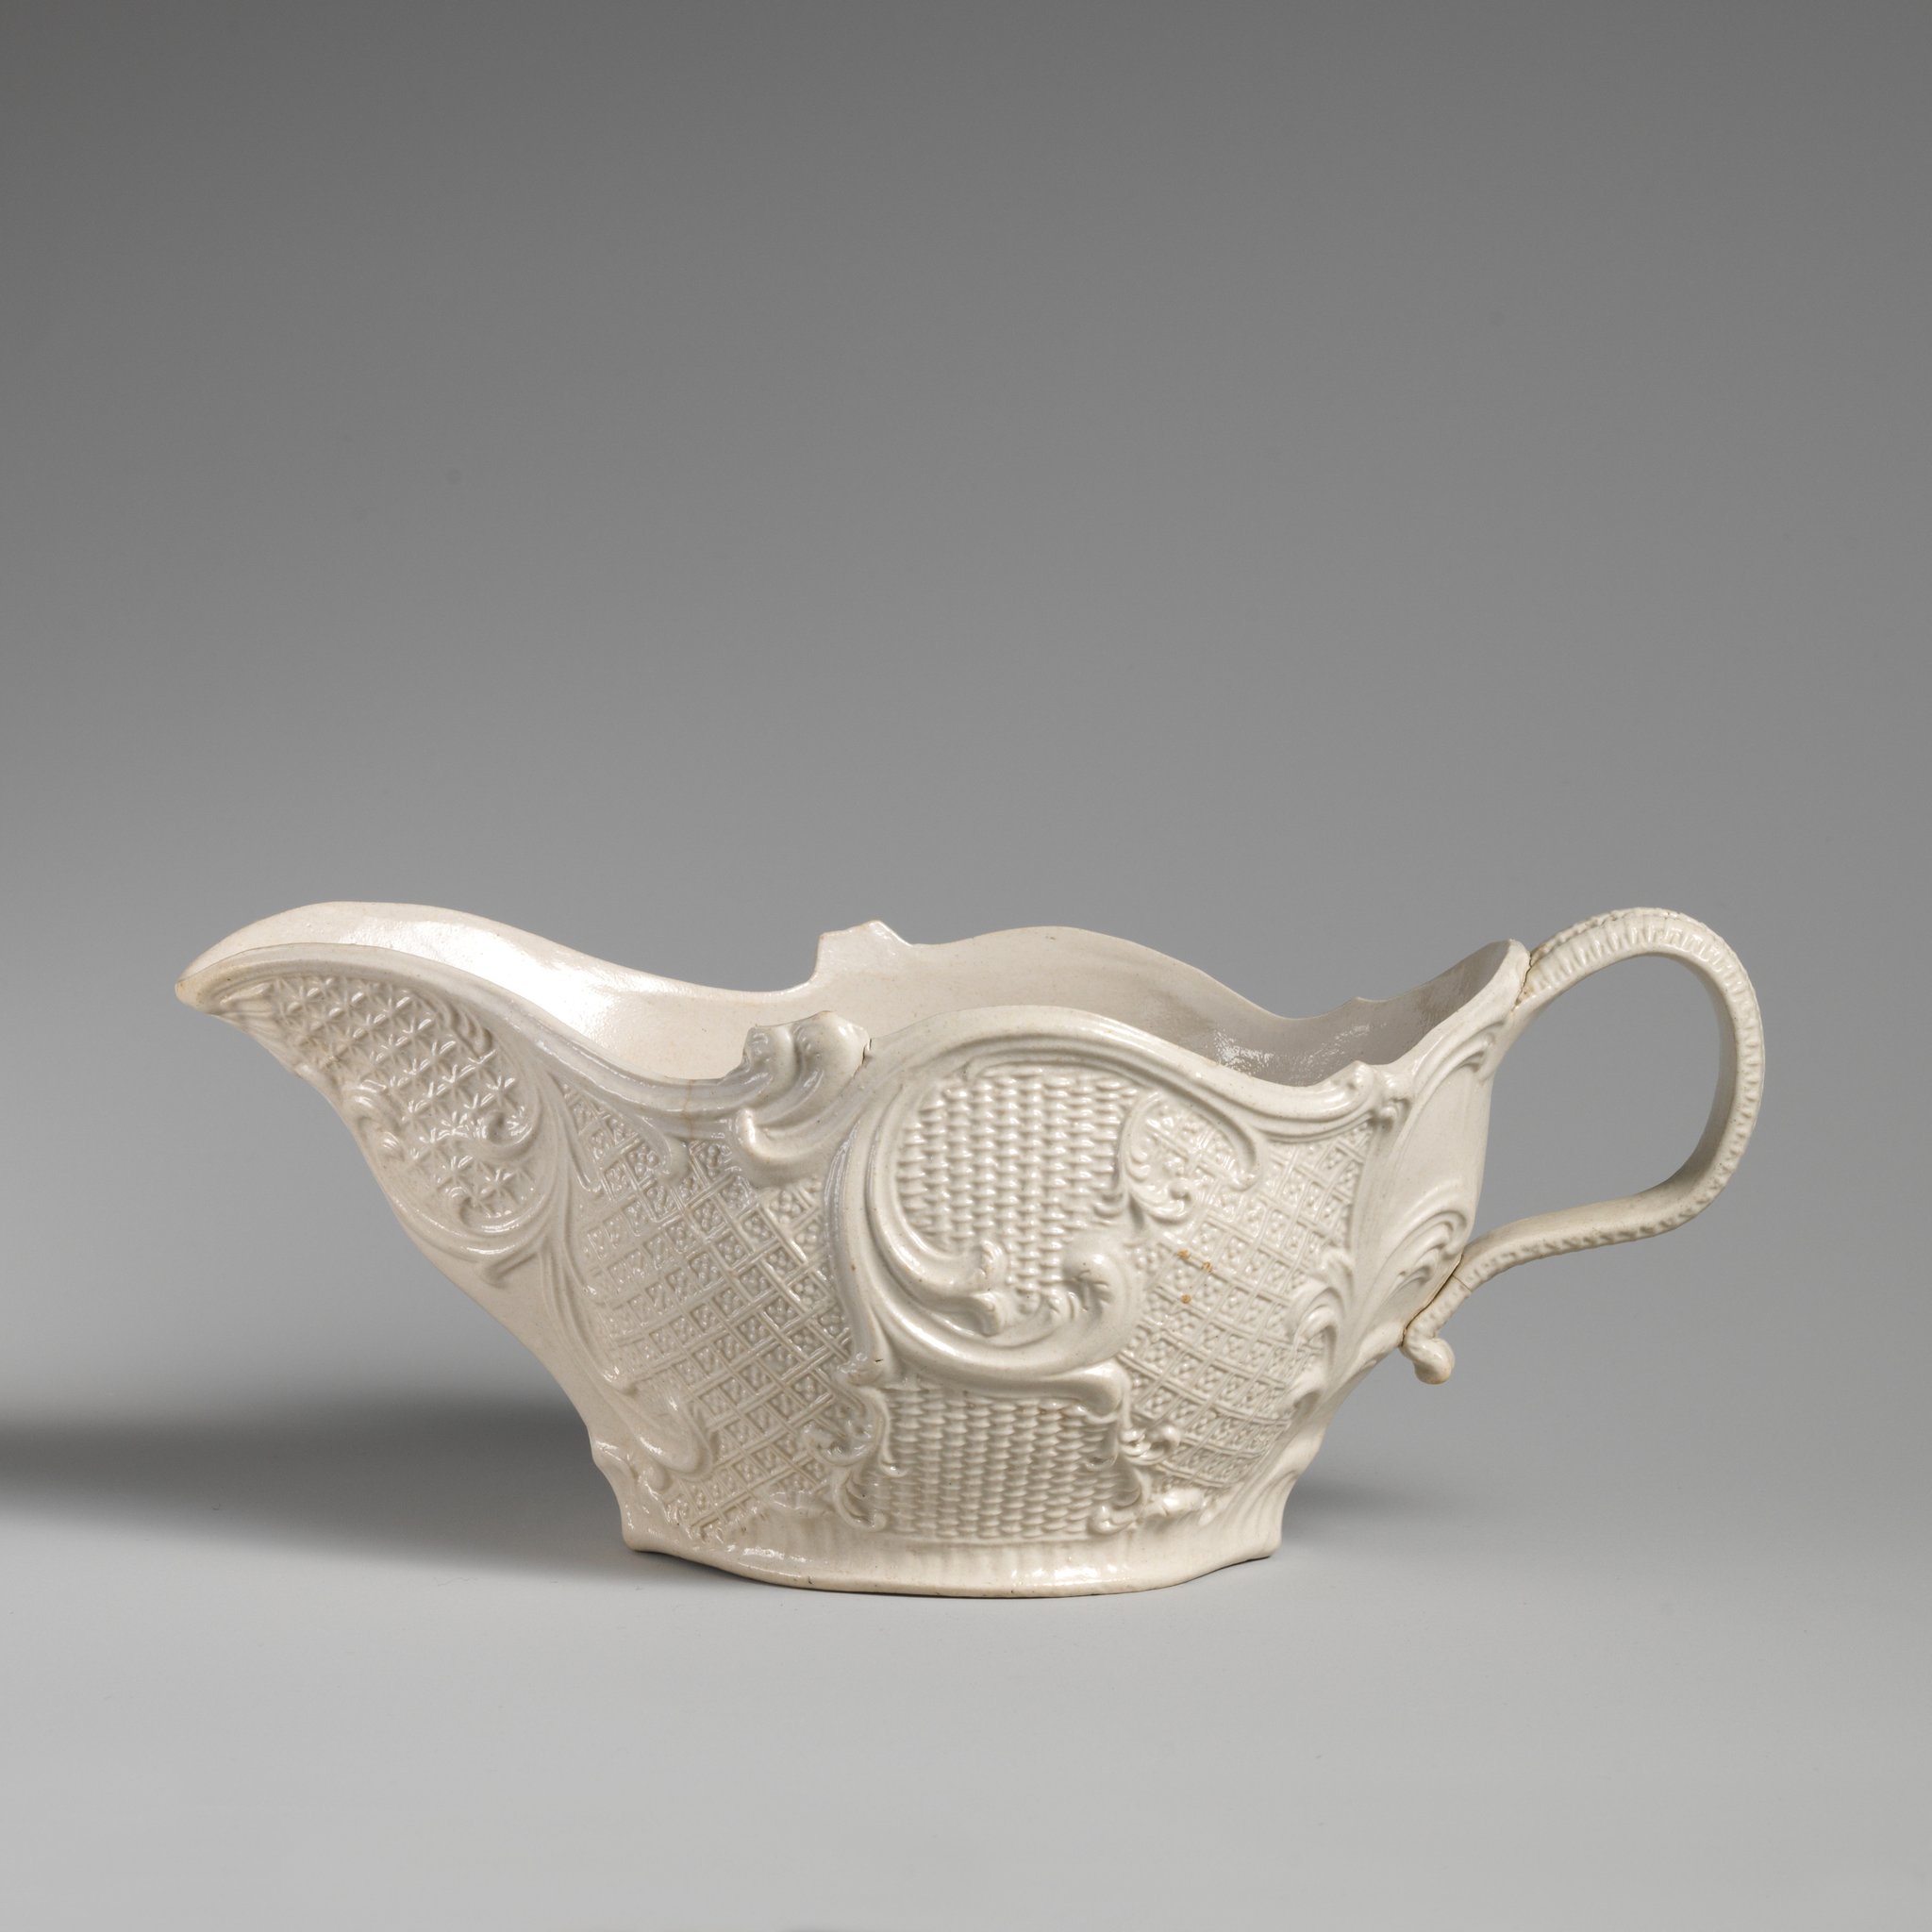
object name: sauceboat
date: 1760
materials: stoneware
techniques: salt glaze